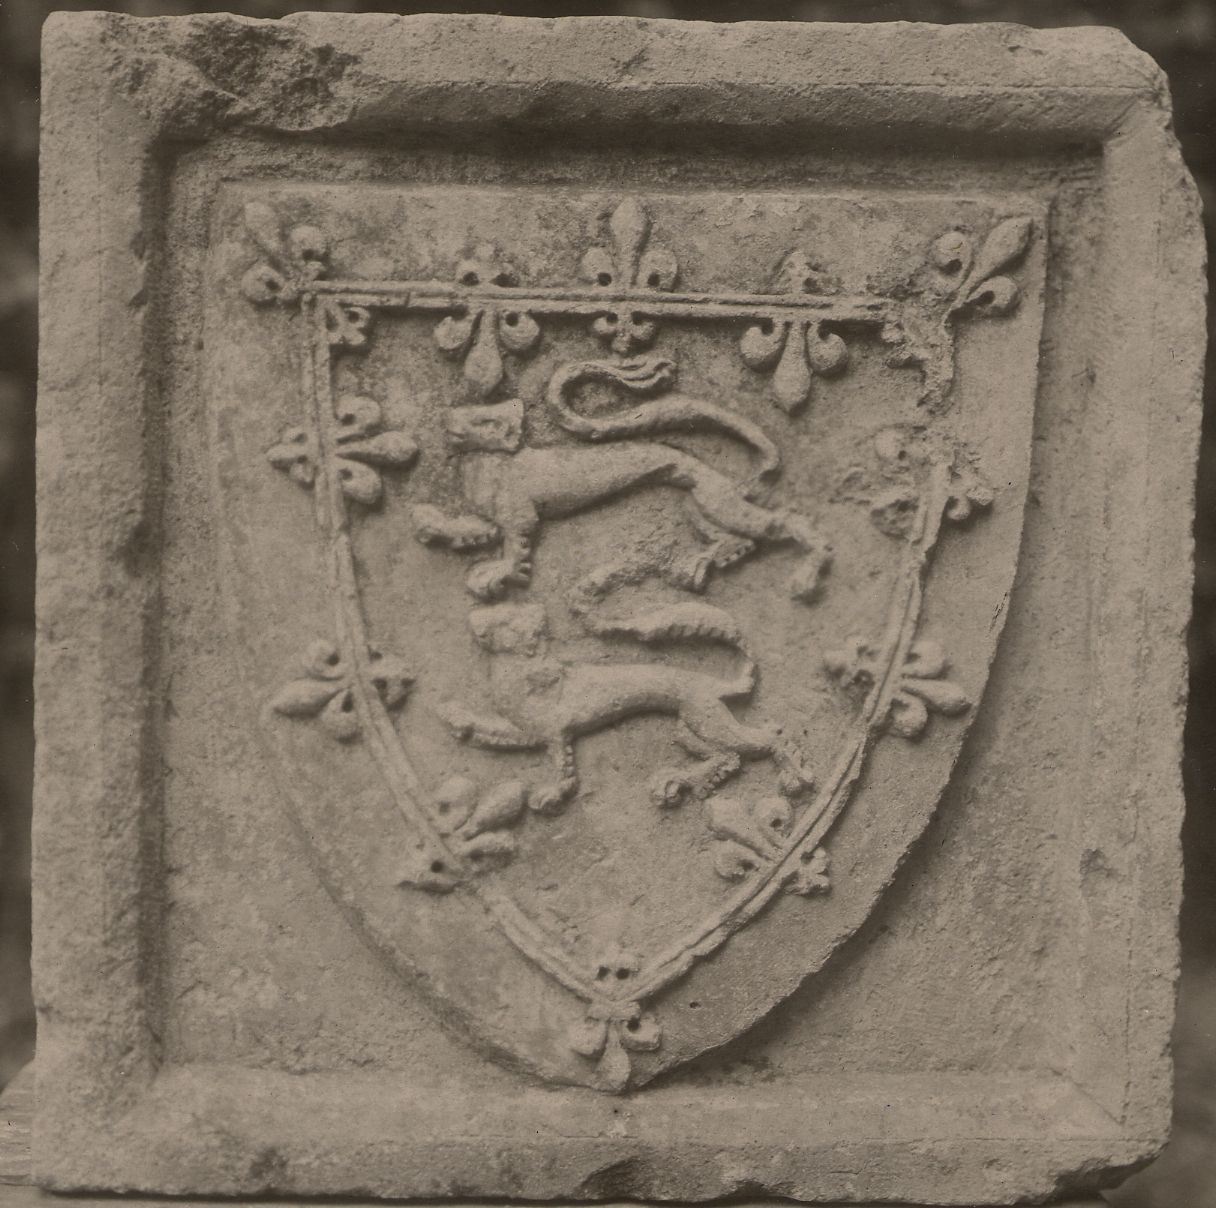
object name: relief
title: Coat of Arms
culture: french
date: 1301-1400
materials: limestone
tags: coat of arms